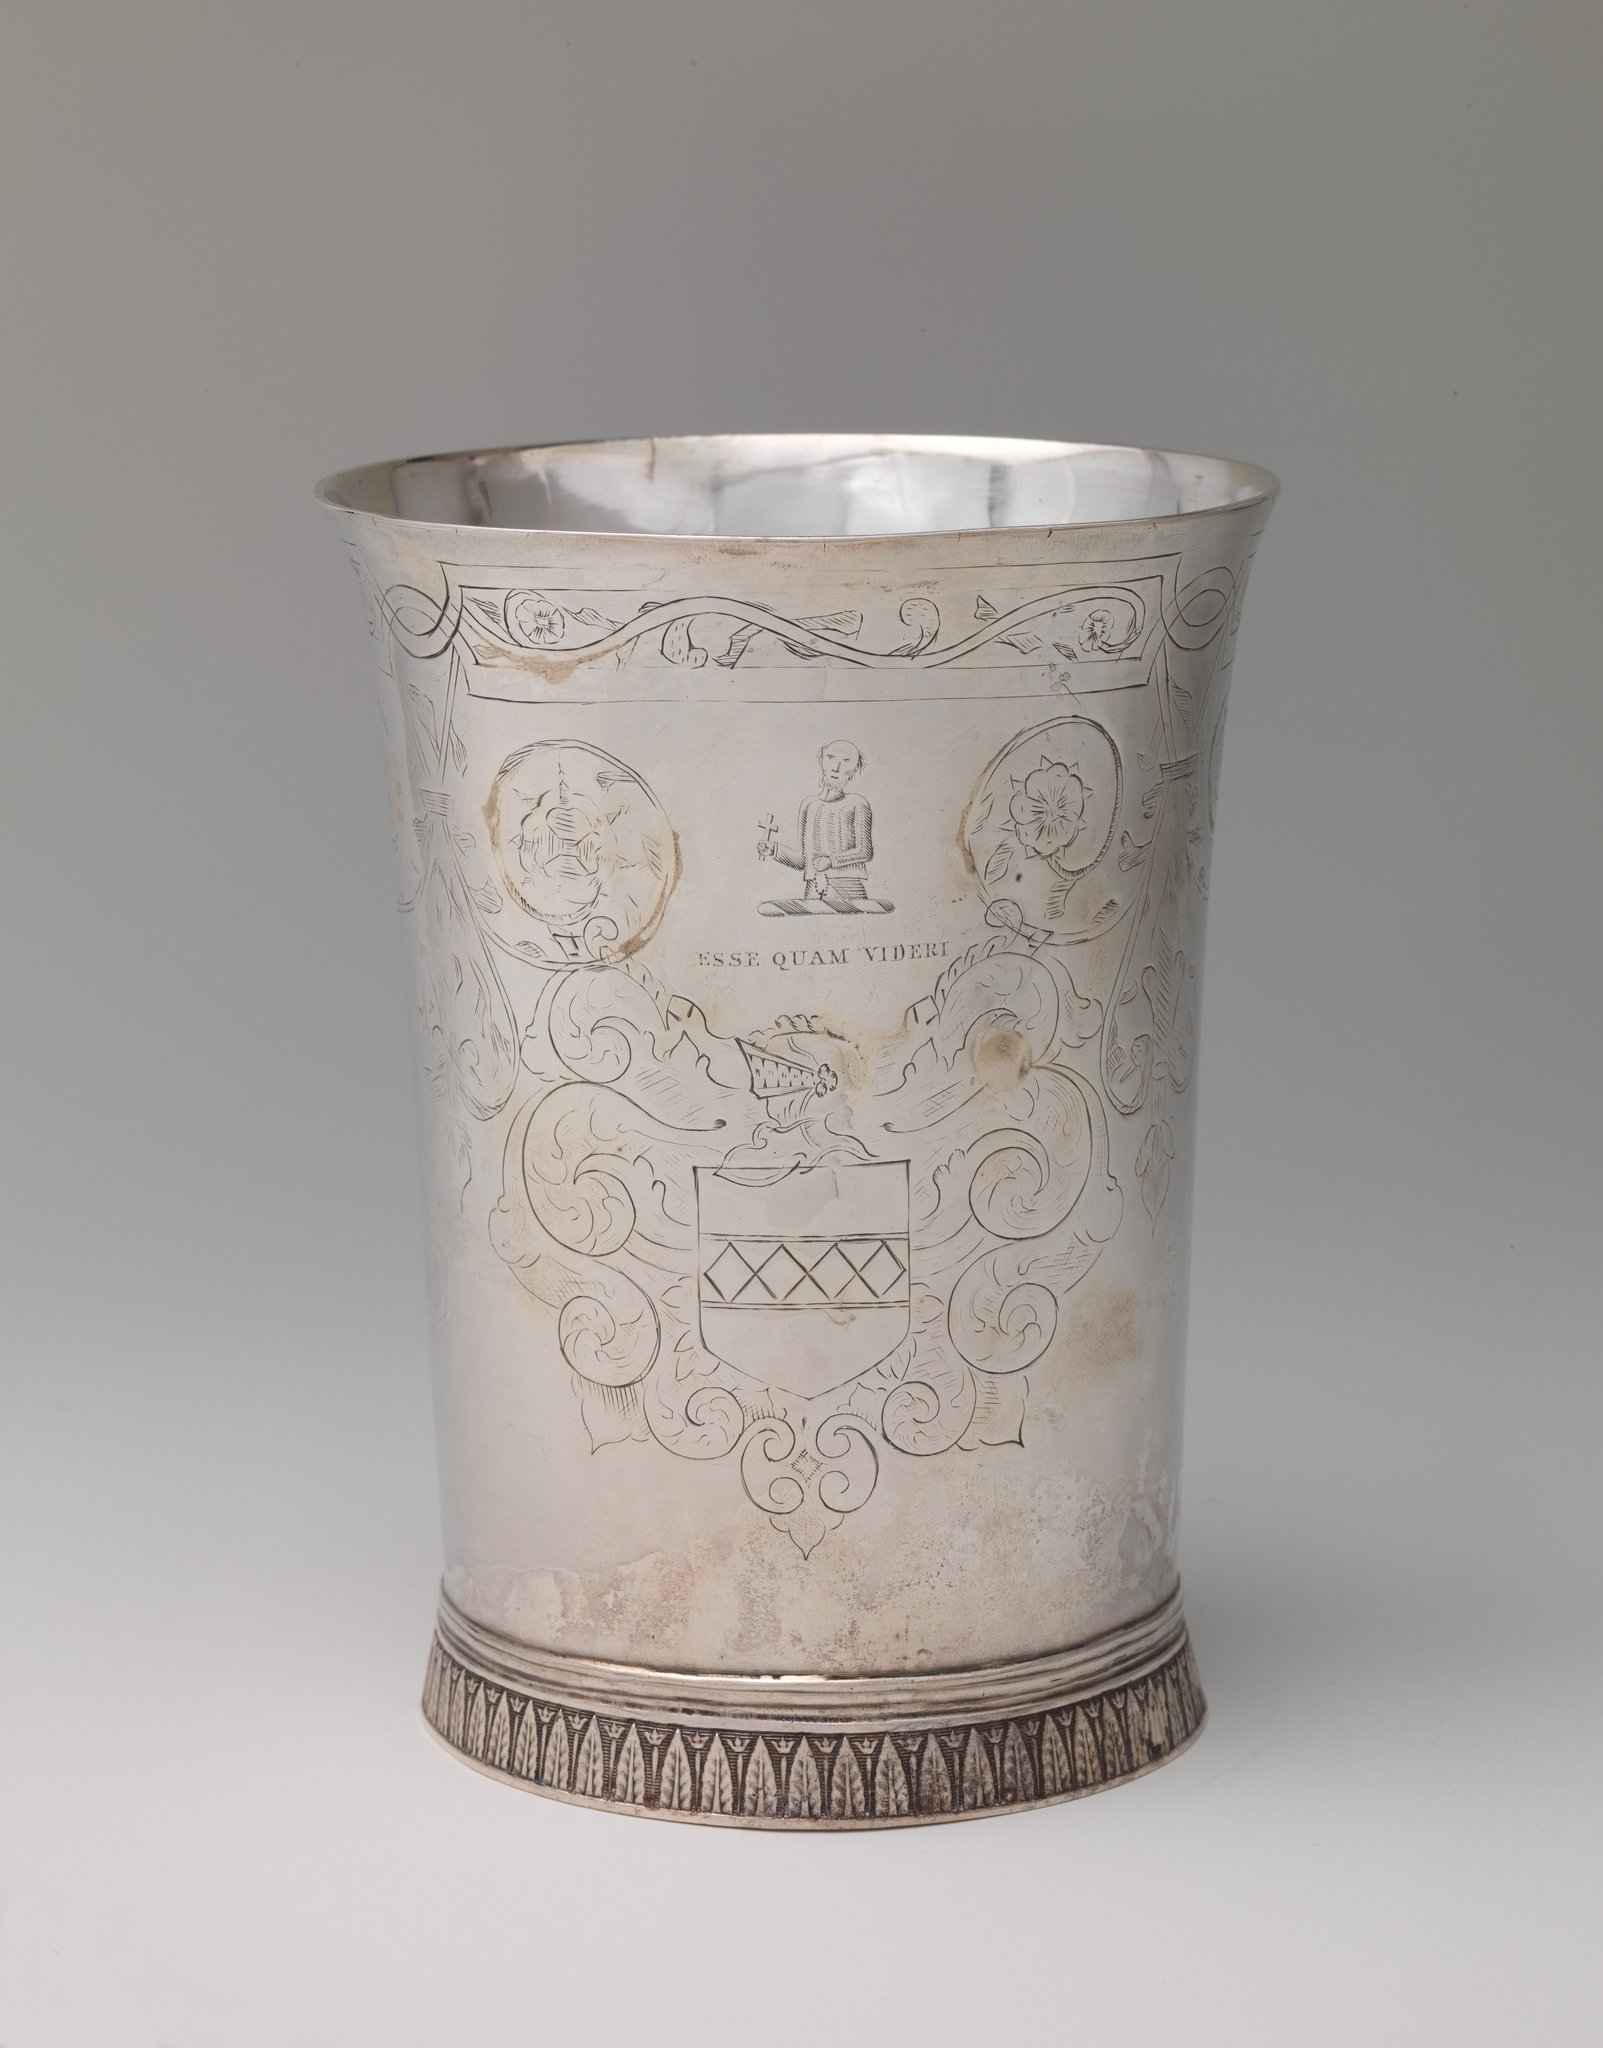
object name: beaker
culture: american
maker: john hull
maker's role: maker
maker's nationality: american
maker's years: 1624-1683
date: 1670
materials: silver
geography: united states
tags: coat of arms